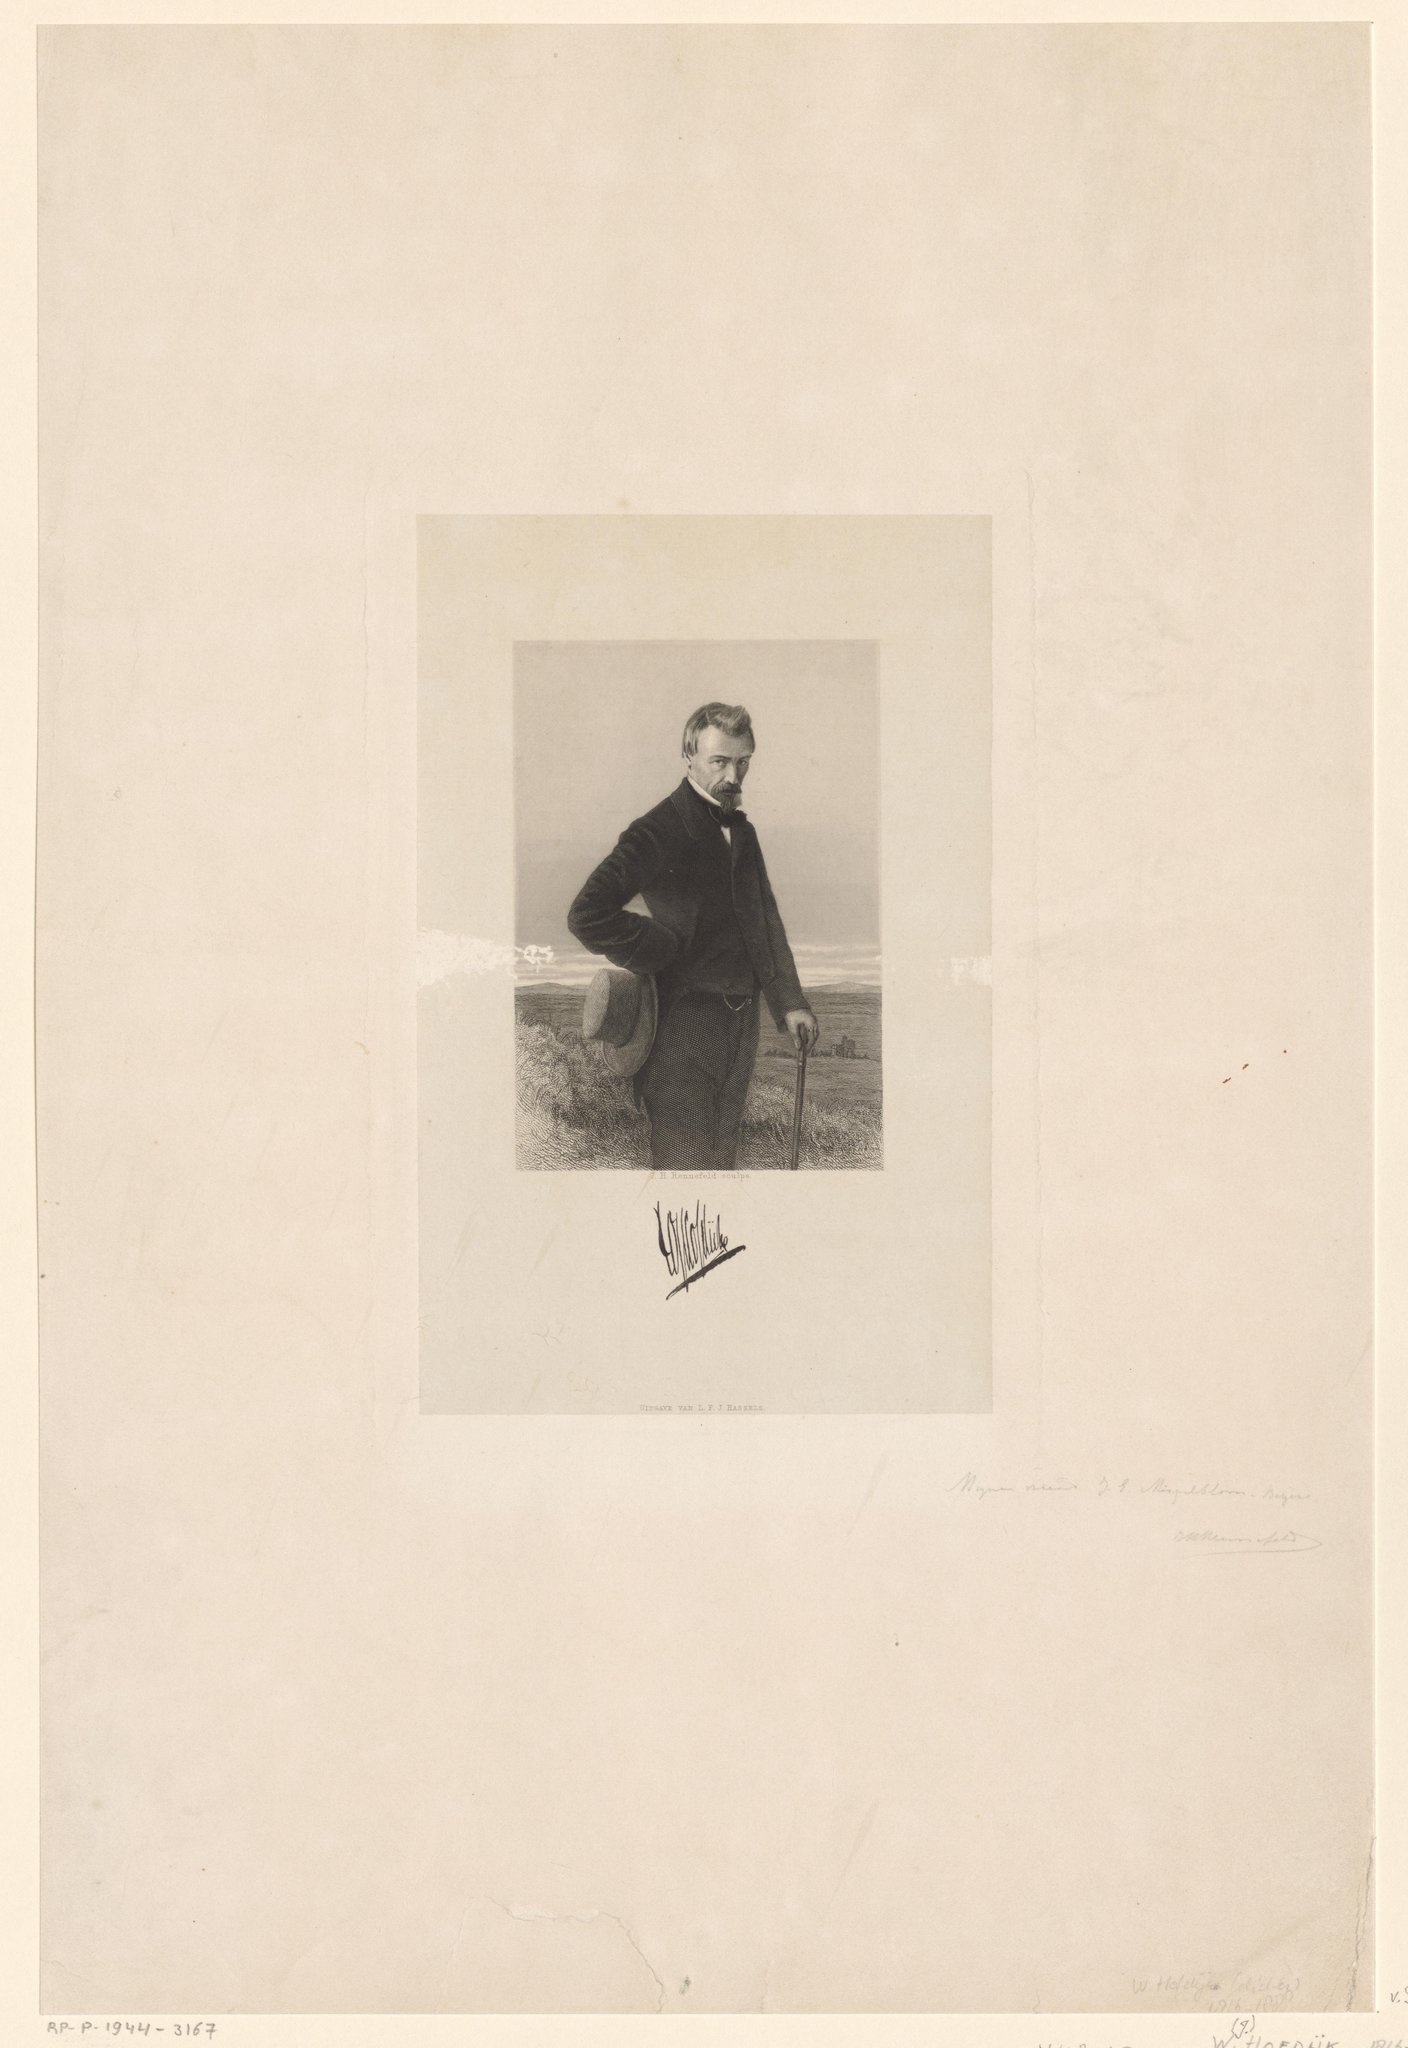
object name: print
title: Portret van Willem Jacobs Hofdijk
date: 1842-1877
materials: paper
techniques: engraving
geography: amsterdam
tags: arnhem, landscapes in the temperate zone, historical persons, portrait of a writer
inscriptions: collector's mark: Lugt 2228